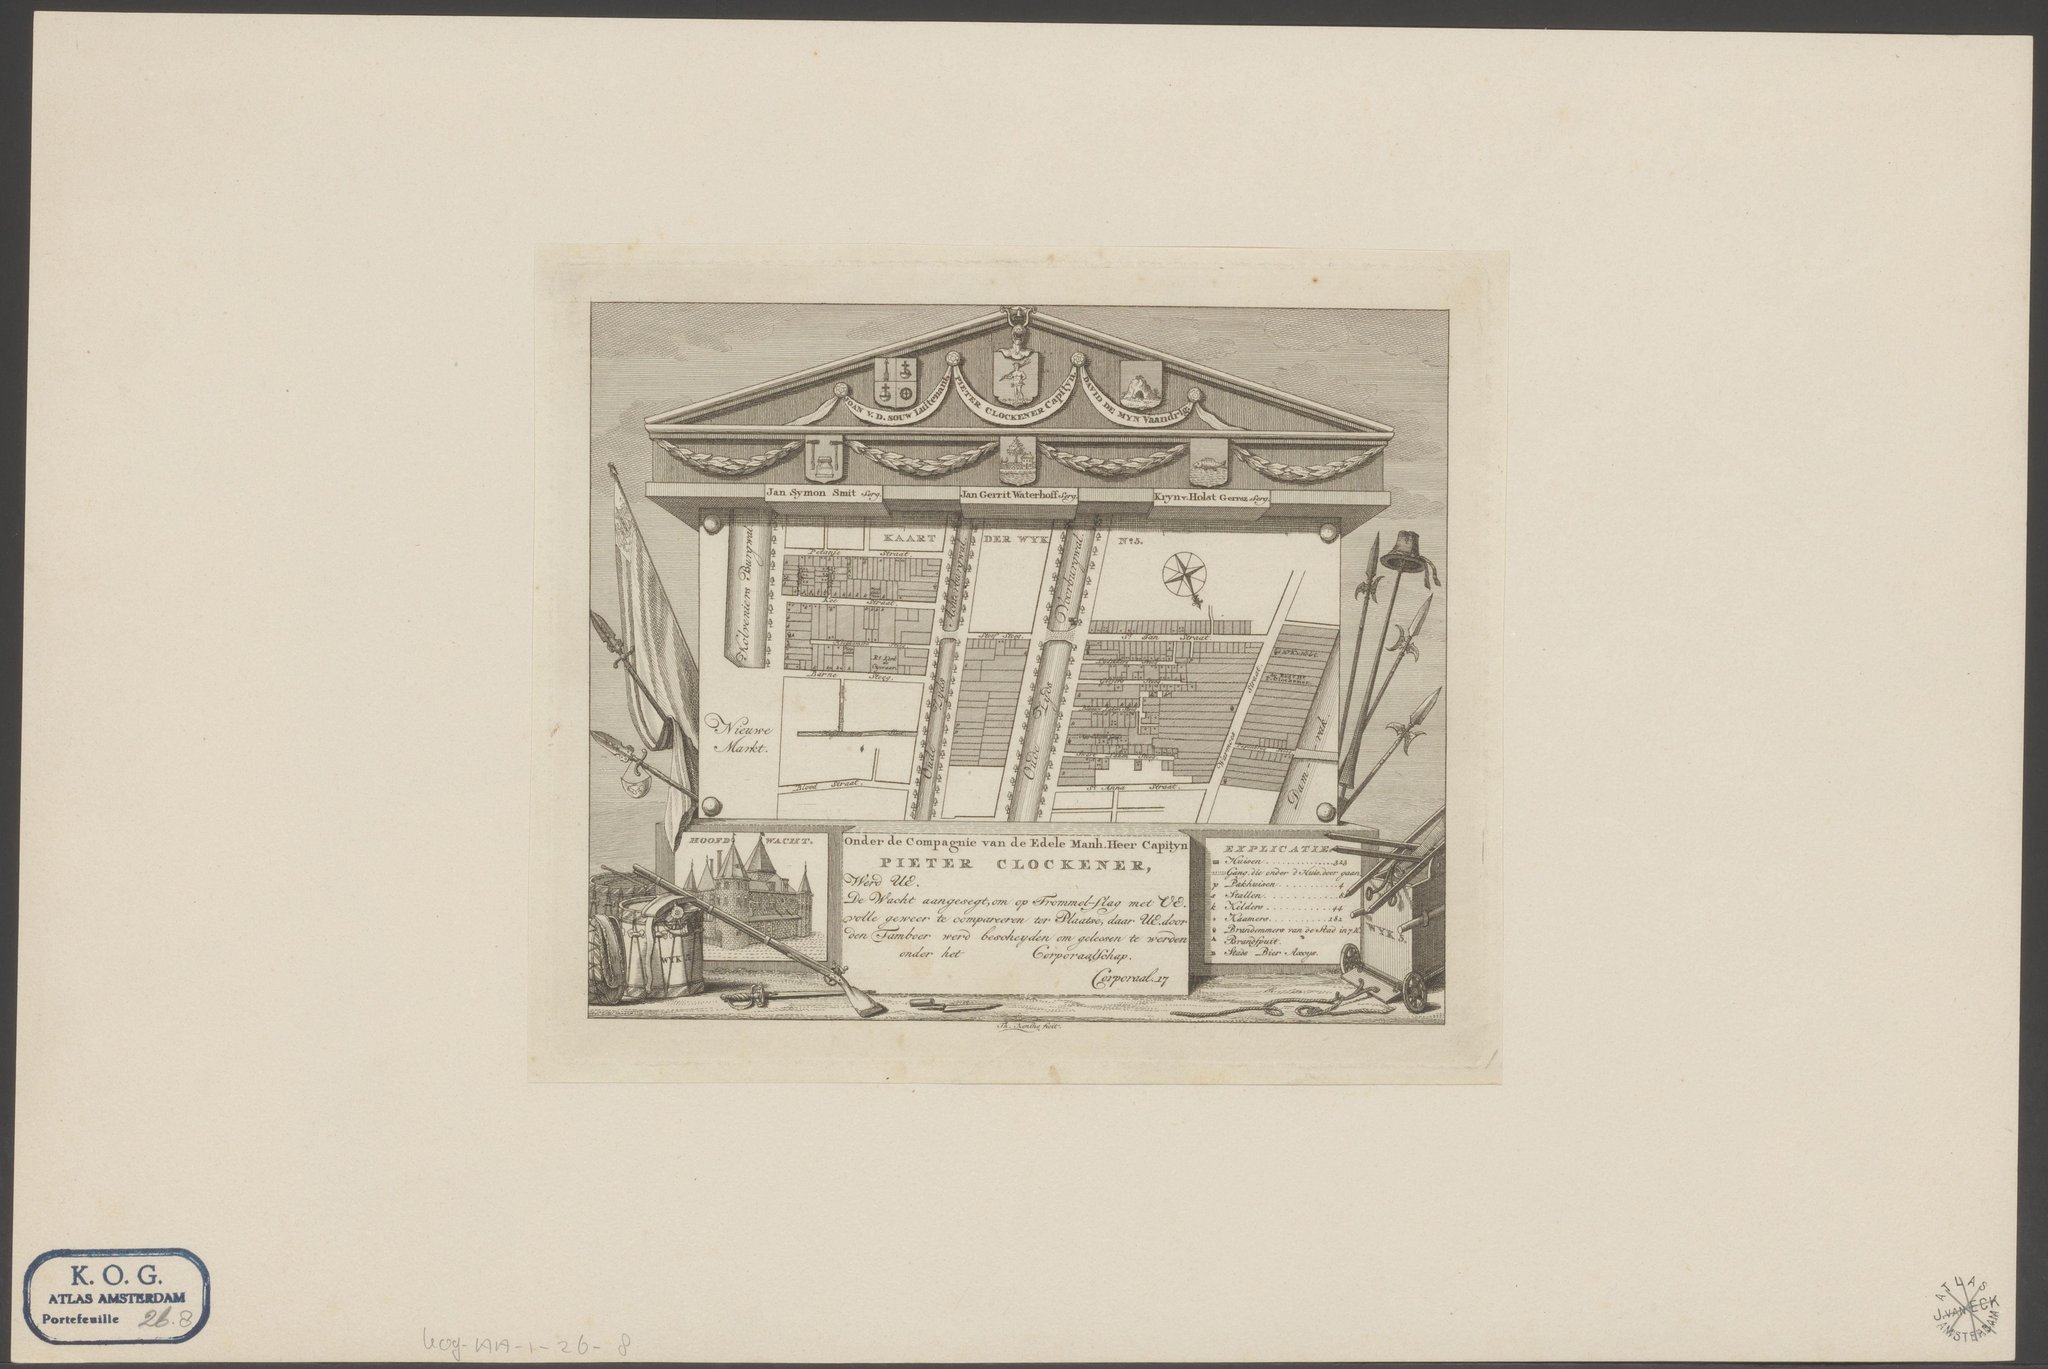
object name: schuttersbiljet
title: Schuttersbrief van kapitein Pieter Clockener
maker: theodoor koning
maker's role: print maker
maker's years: 1748-1829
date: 1779-1787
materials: paper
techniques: engraving, etching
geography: amsterdam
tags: helved weapons, polearms (for striking, hacking, thrusting): lance, firearms, maps of cities, armorial bearing, heraldry, amsterdam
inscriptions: collector's mark: Lugt 800a, collector's mark: Lugt 800a, collector's mark: Lugt 1641b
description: Van deze schuttersbrief komen minstens vier staten voor: zonder tekst en zonder datering onderaan, zonder tekst en met datering onderaan, met tekst en zonder datering onderaan, en met tekst en met datering onderaan. Hier is sprake van de derde situatie.